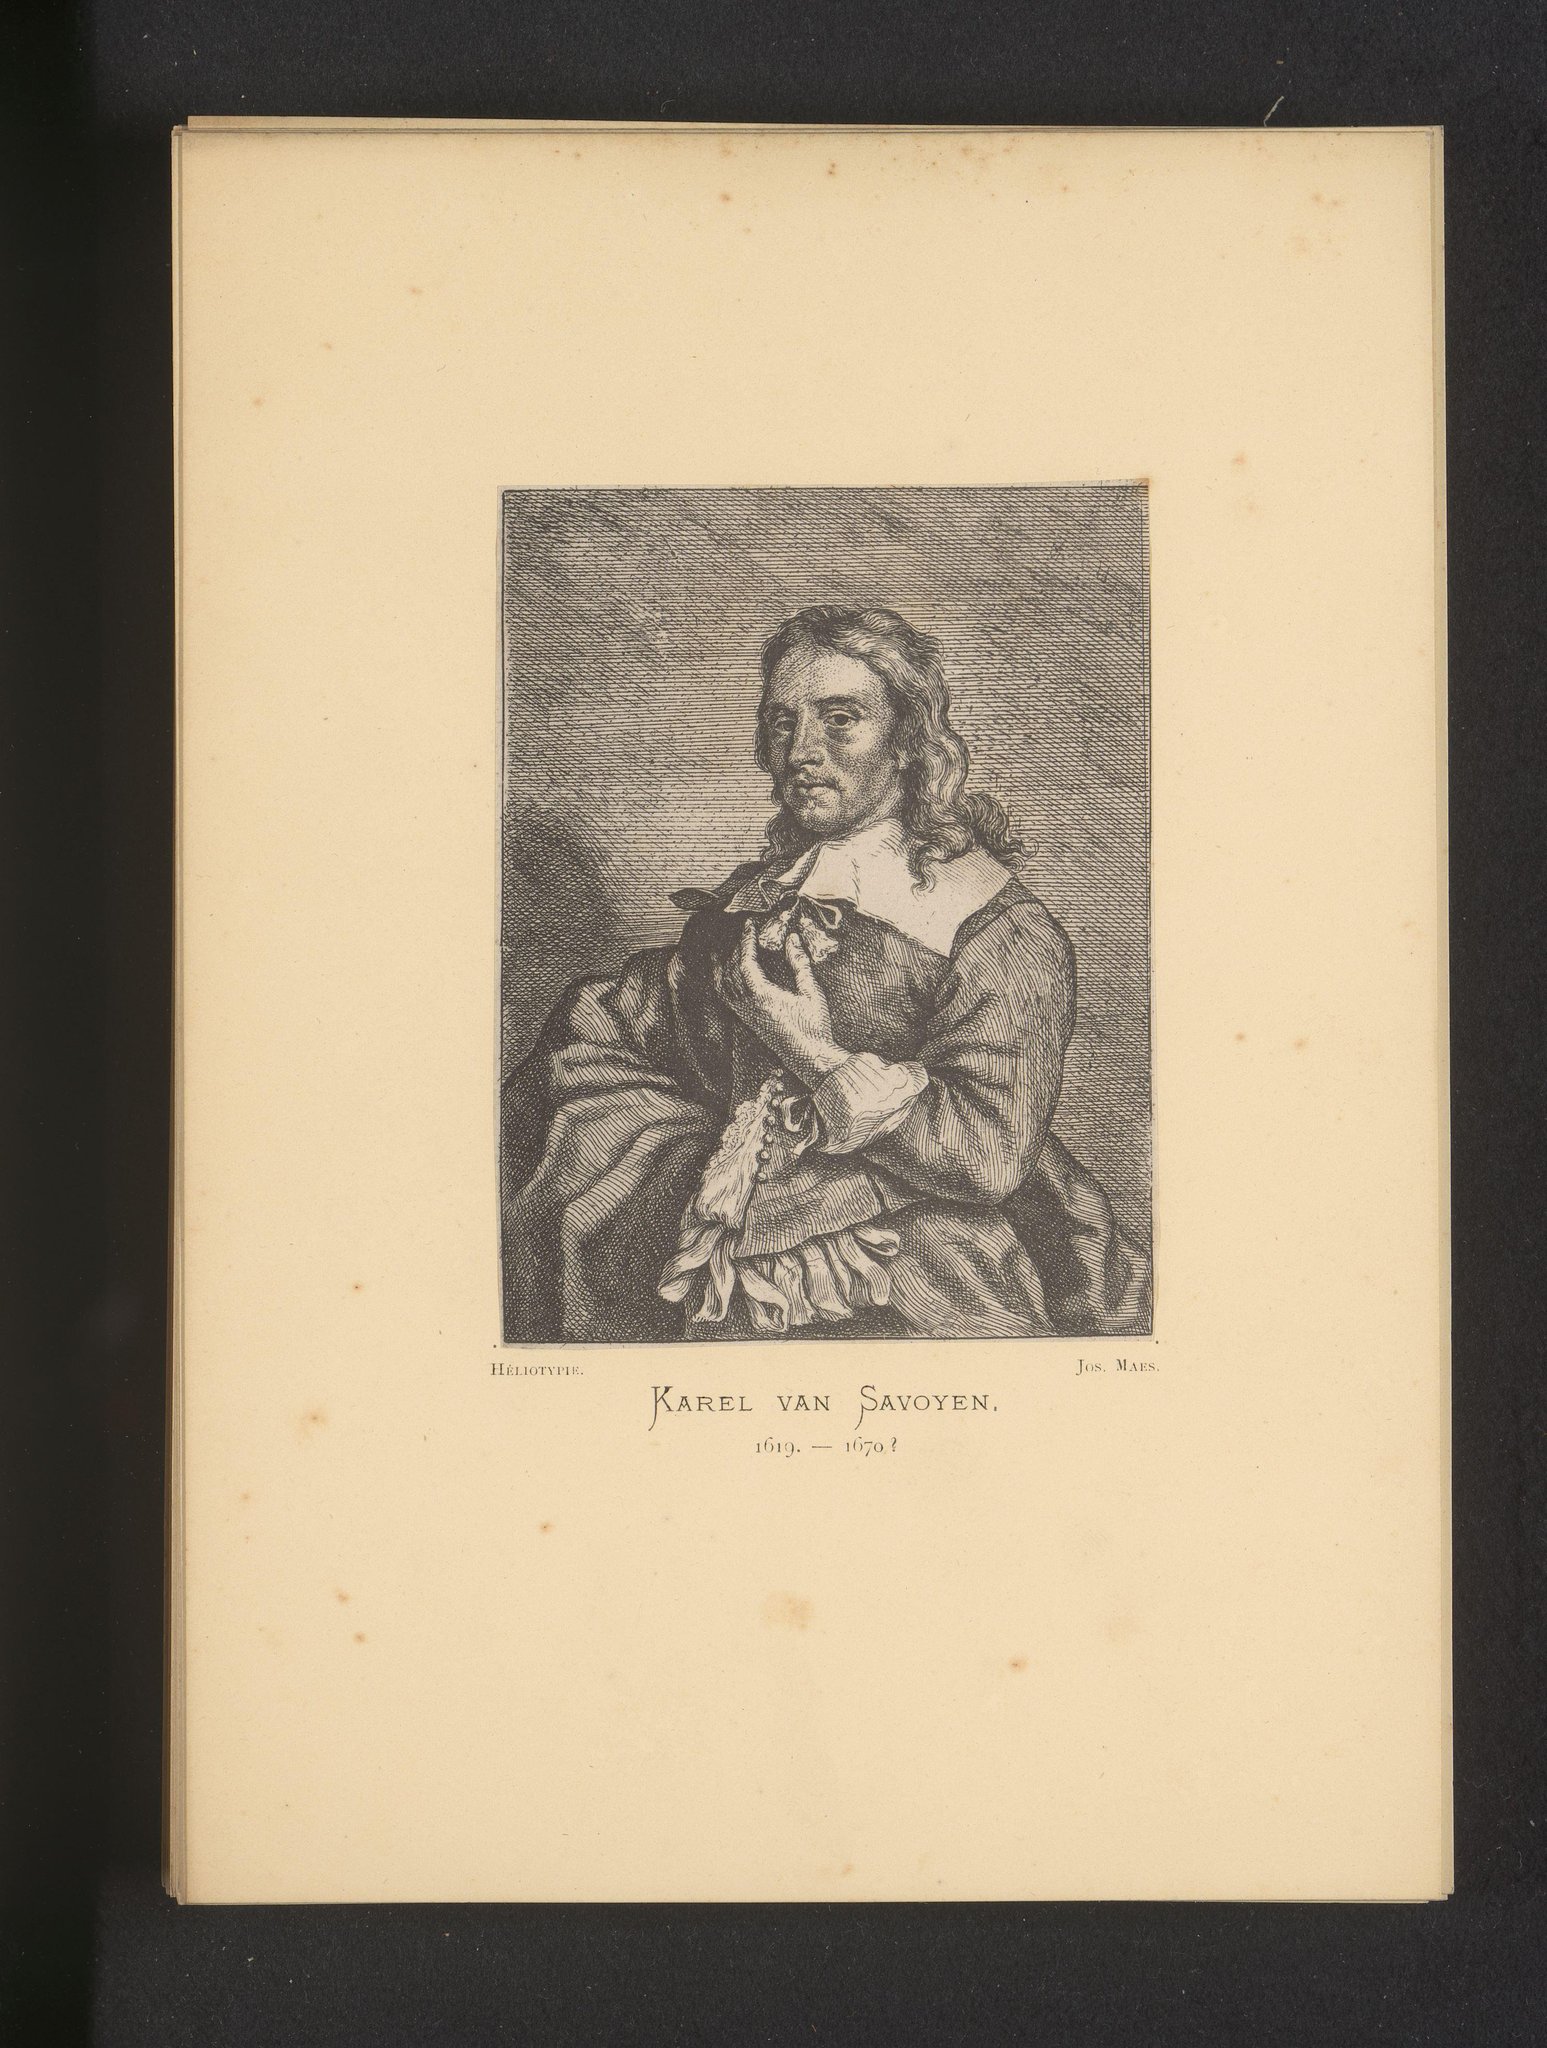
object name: photomechanical print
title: Reproductie van een ets van een zelfportret van Carel van Savoyen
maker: joseph maes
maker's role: fotograaf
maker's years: 1838-1908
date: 1872-1877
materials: cardboard, paper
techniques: photograph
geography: antwerp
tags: antwerp, amsterdam, carel van savoyen, historical persons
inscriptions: inscription: ‘1619. - 1670?’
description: Deze prent maakt deel uit van een omslag met 150 prenten en een katern met een lijst van afbeeldingen.